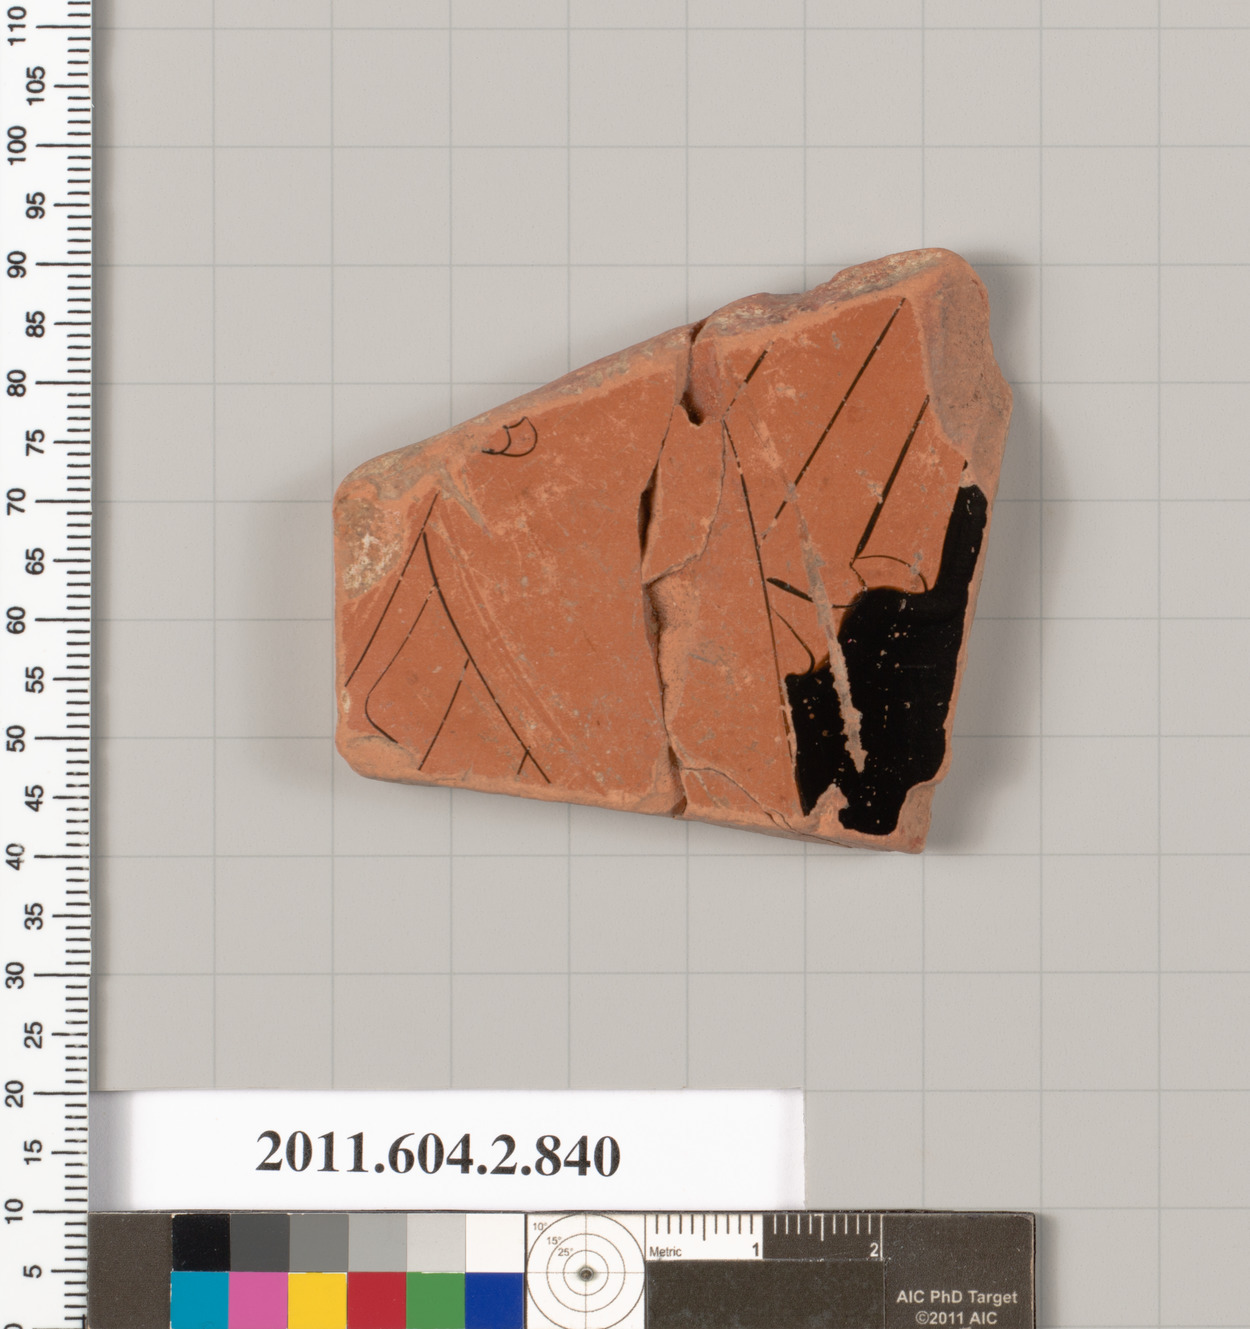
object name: bell krater fragment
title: Terracotta fragment of a bell-krater (bowl for mixing wine and water)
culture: greek, attic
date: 460-450 BCE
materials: terracotta